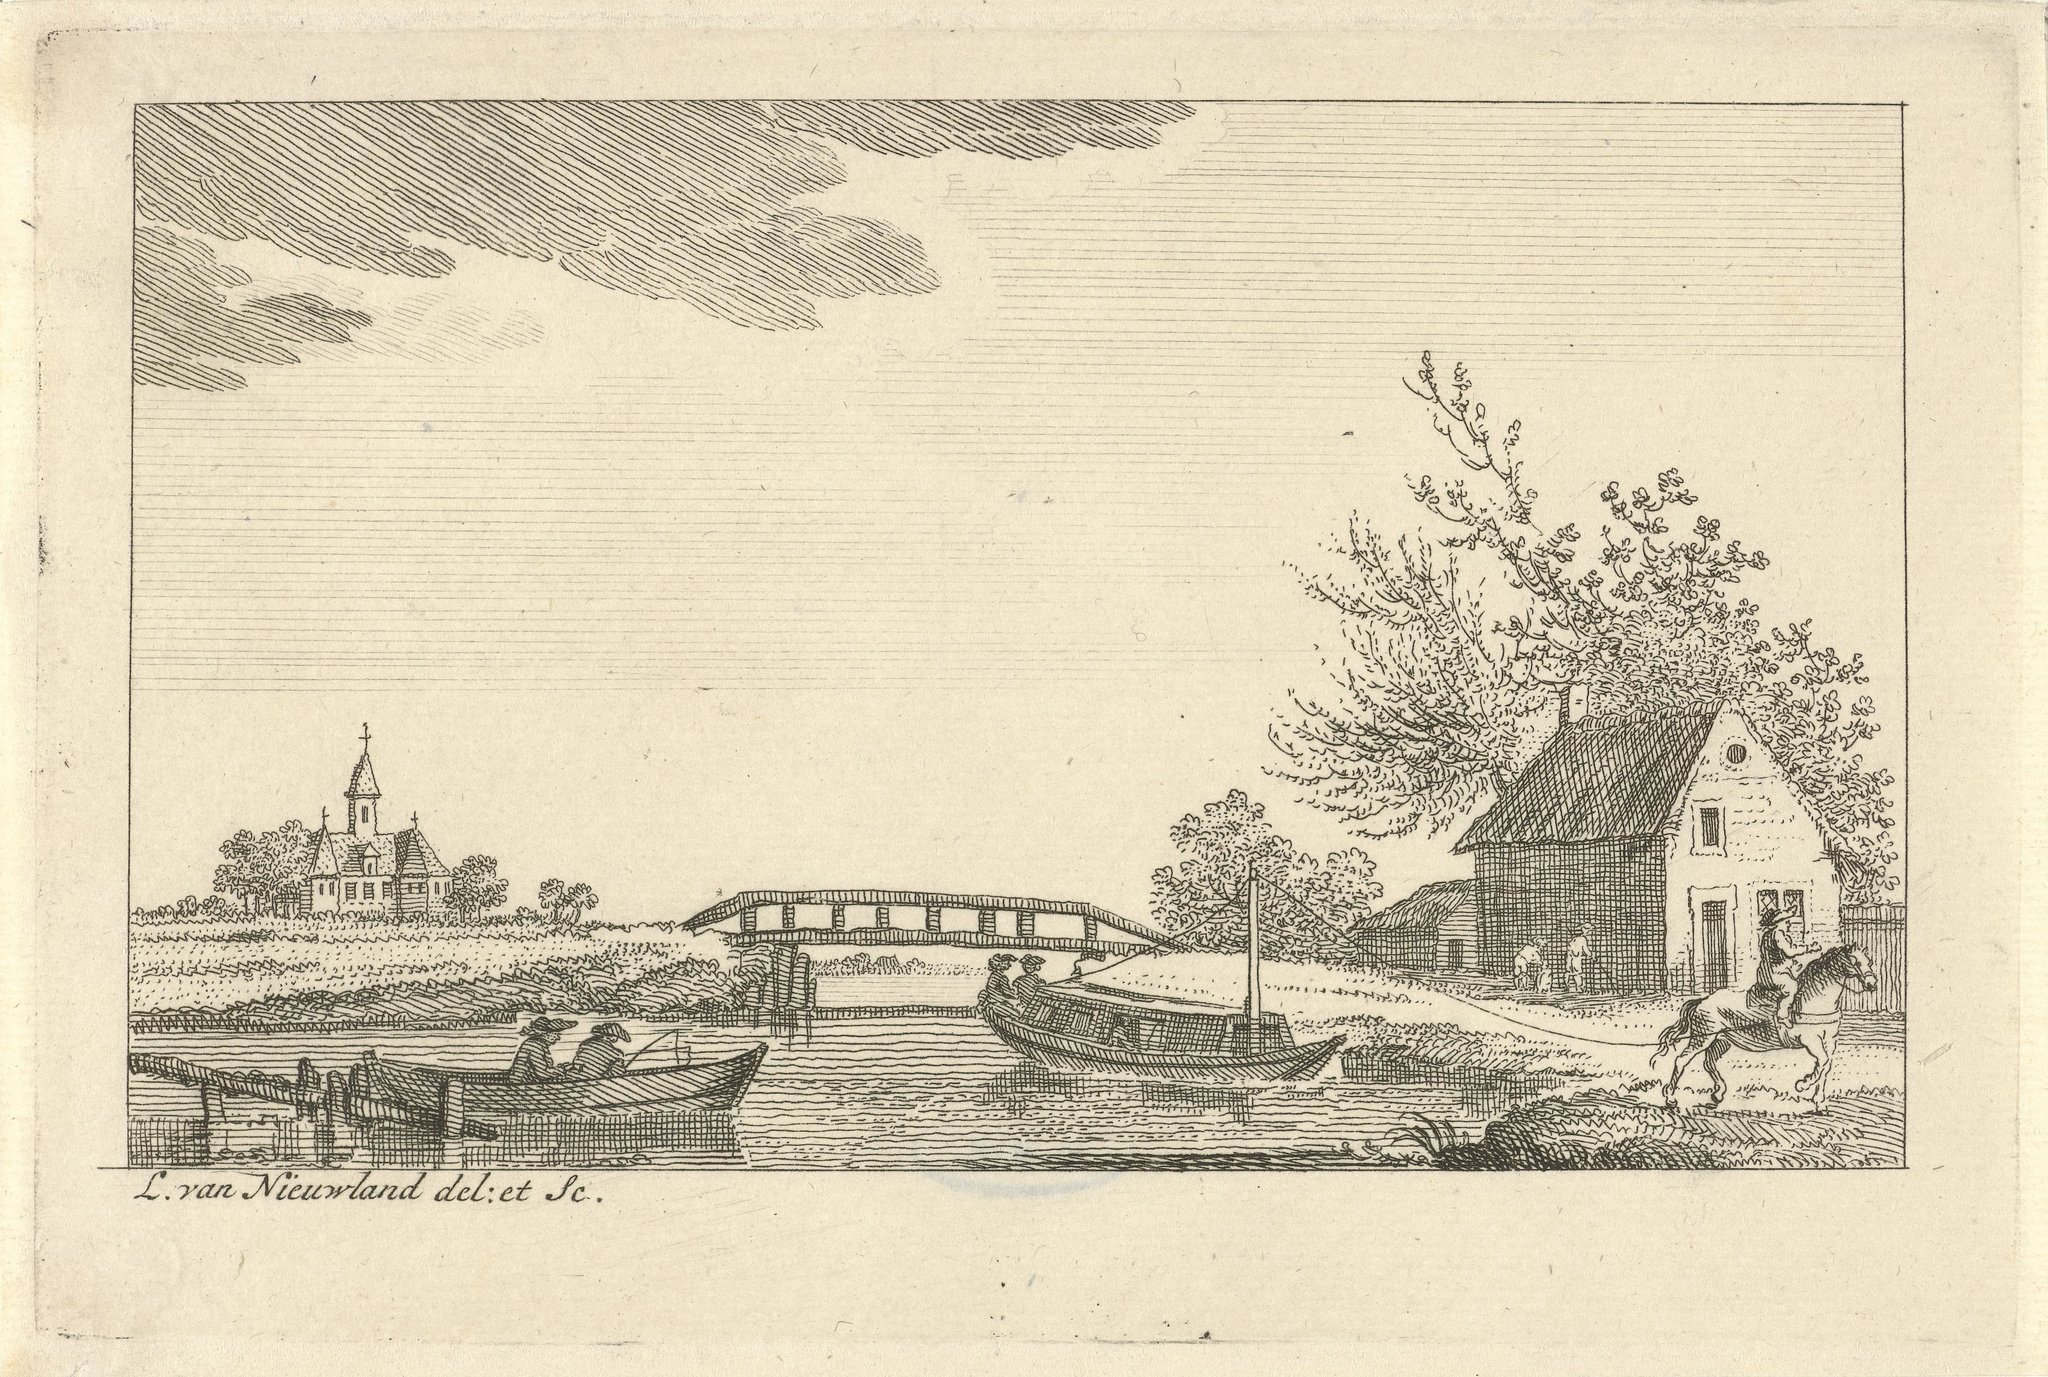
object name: print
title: Twaalf Hollandse landschappen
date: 1763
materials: paper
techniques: etching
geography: amsterdam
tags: landscapes with waters, waterscapes, seascapes (in the temperate zone), tow-boat, towing-barge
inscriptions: collector's mark: Lugt 2228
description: Gezicht op een vaart waarin een trekschuit door een man te paard wordt voortgetrokken, links een roeiboot met twee vissende figuren.